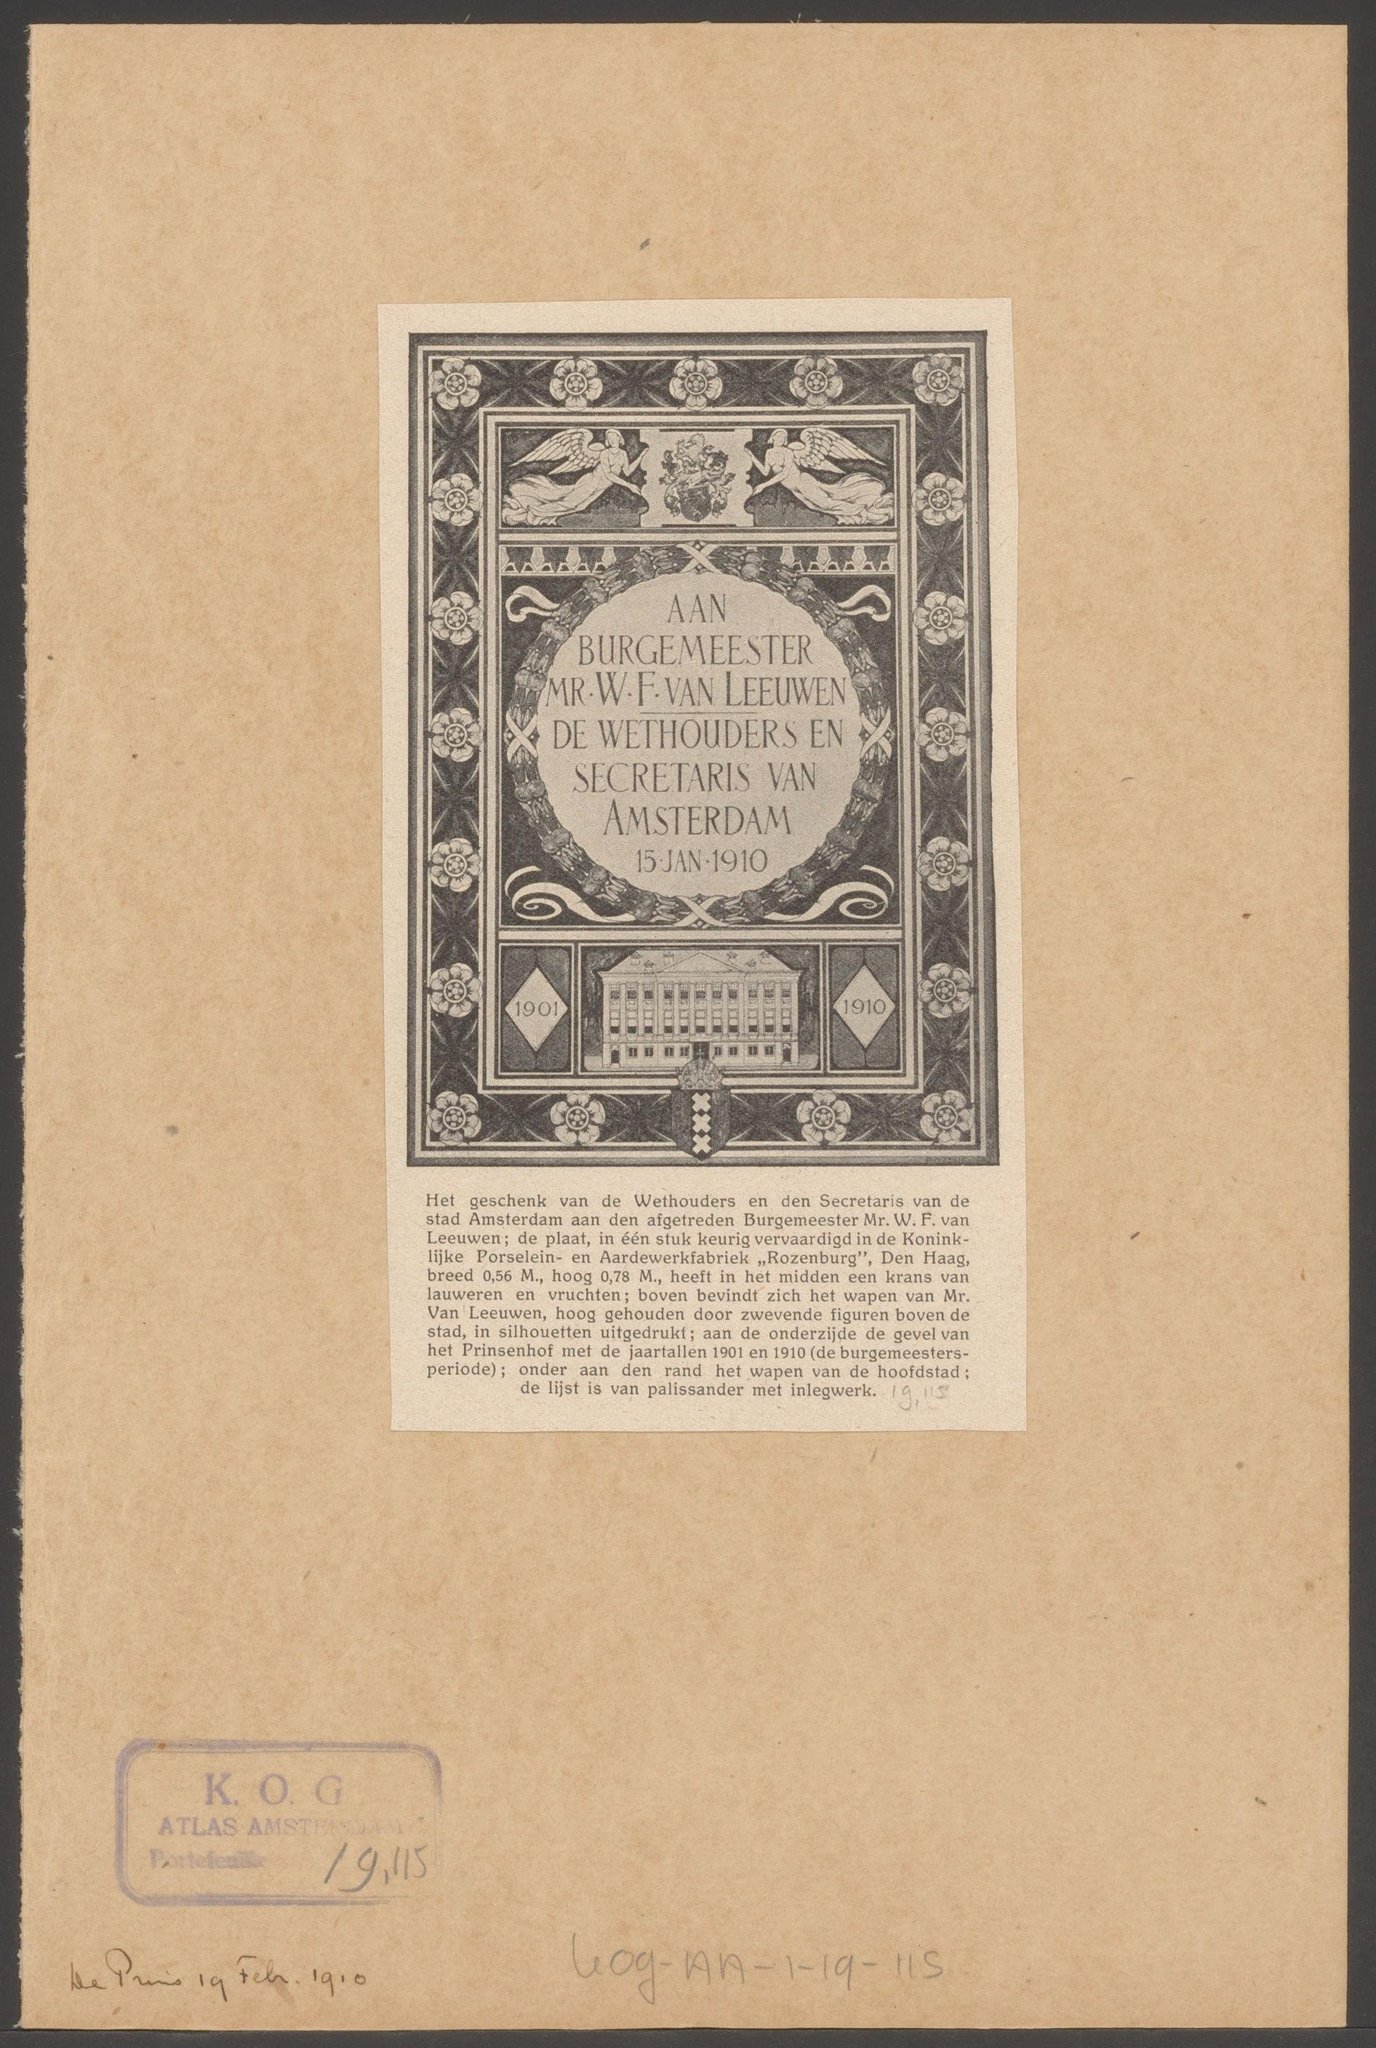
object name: photomechanical print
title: Geschenk aan Wilhelmus Frederik van Leeuwen ter gelegenheid van zijn afscheid als burgemeester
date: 1910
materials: paper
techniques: letterpress printing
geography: amsterdam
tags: surabaya, the hague, mayor, burgomaster, abdication (of a ruler), amsterdam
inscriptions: collector's mark: ‘19,115’ Lugt 1641b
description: Onderwerpsrubriek binnen de Atlas Amsterdam: Herinneringen aan regeringsleden en hunne huisgezinnen [na 1800].